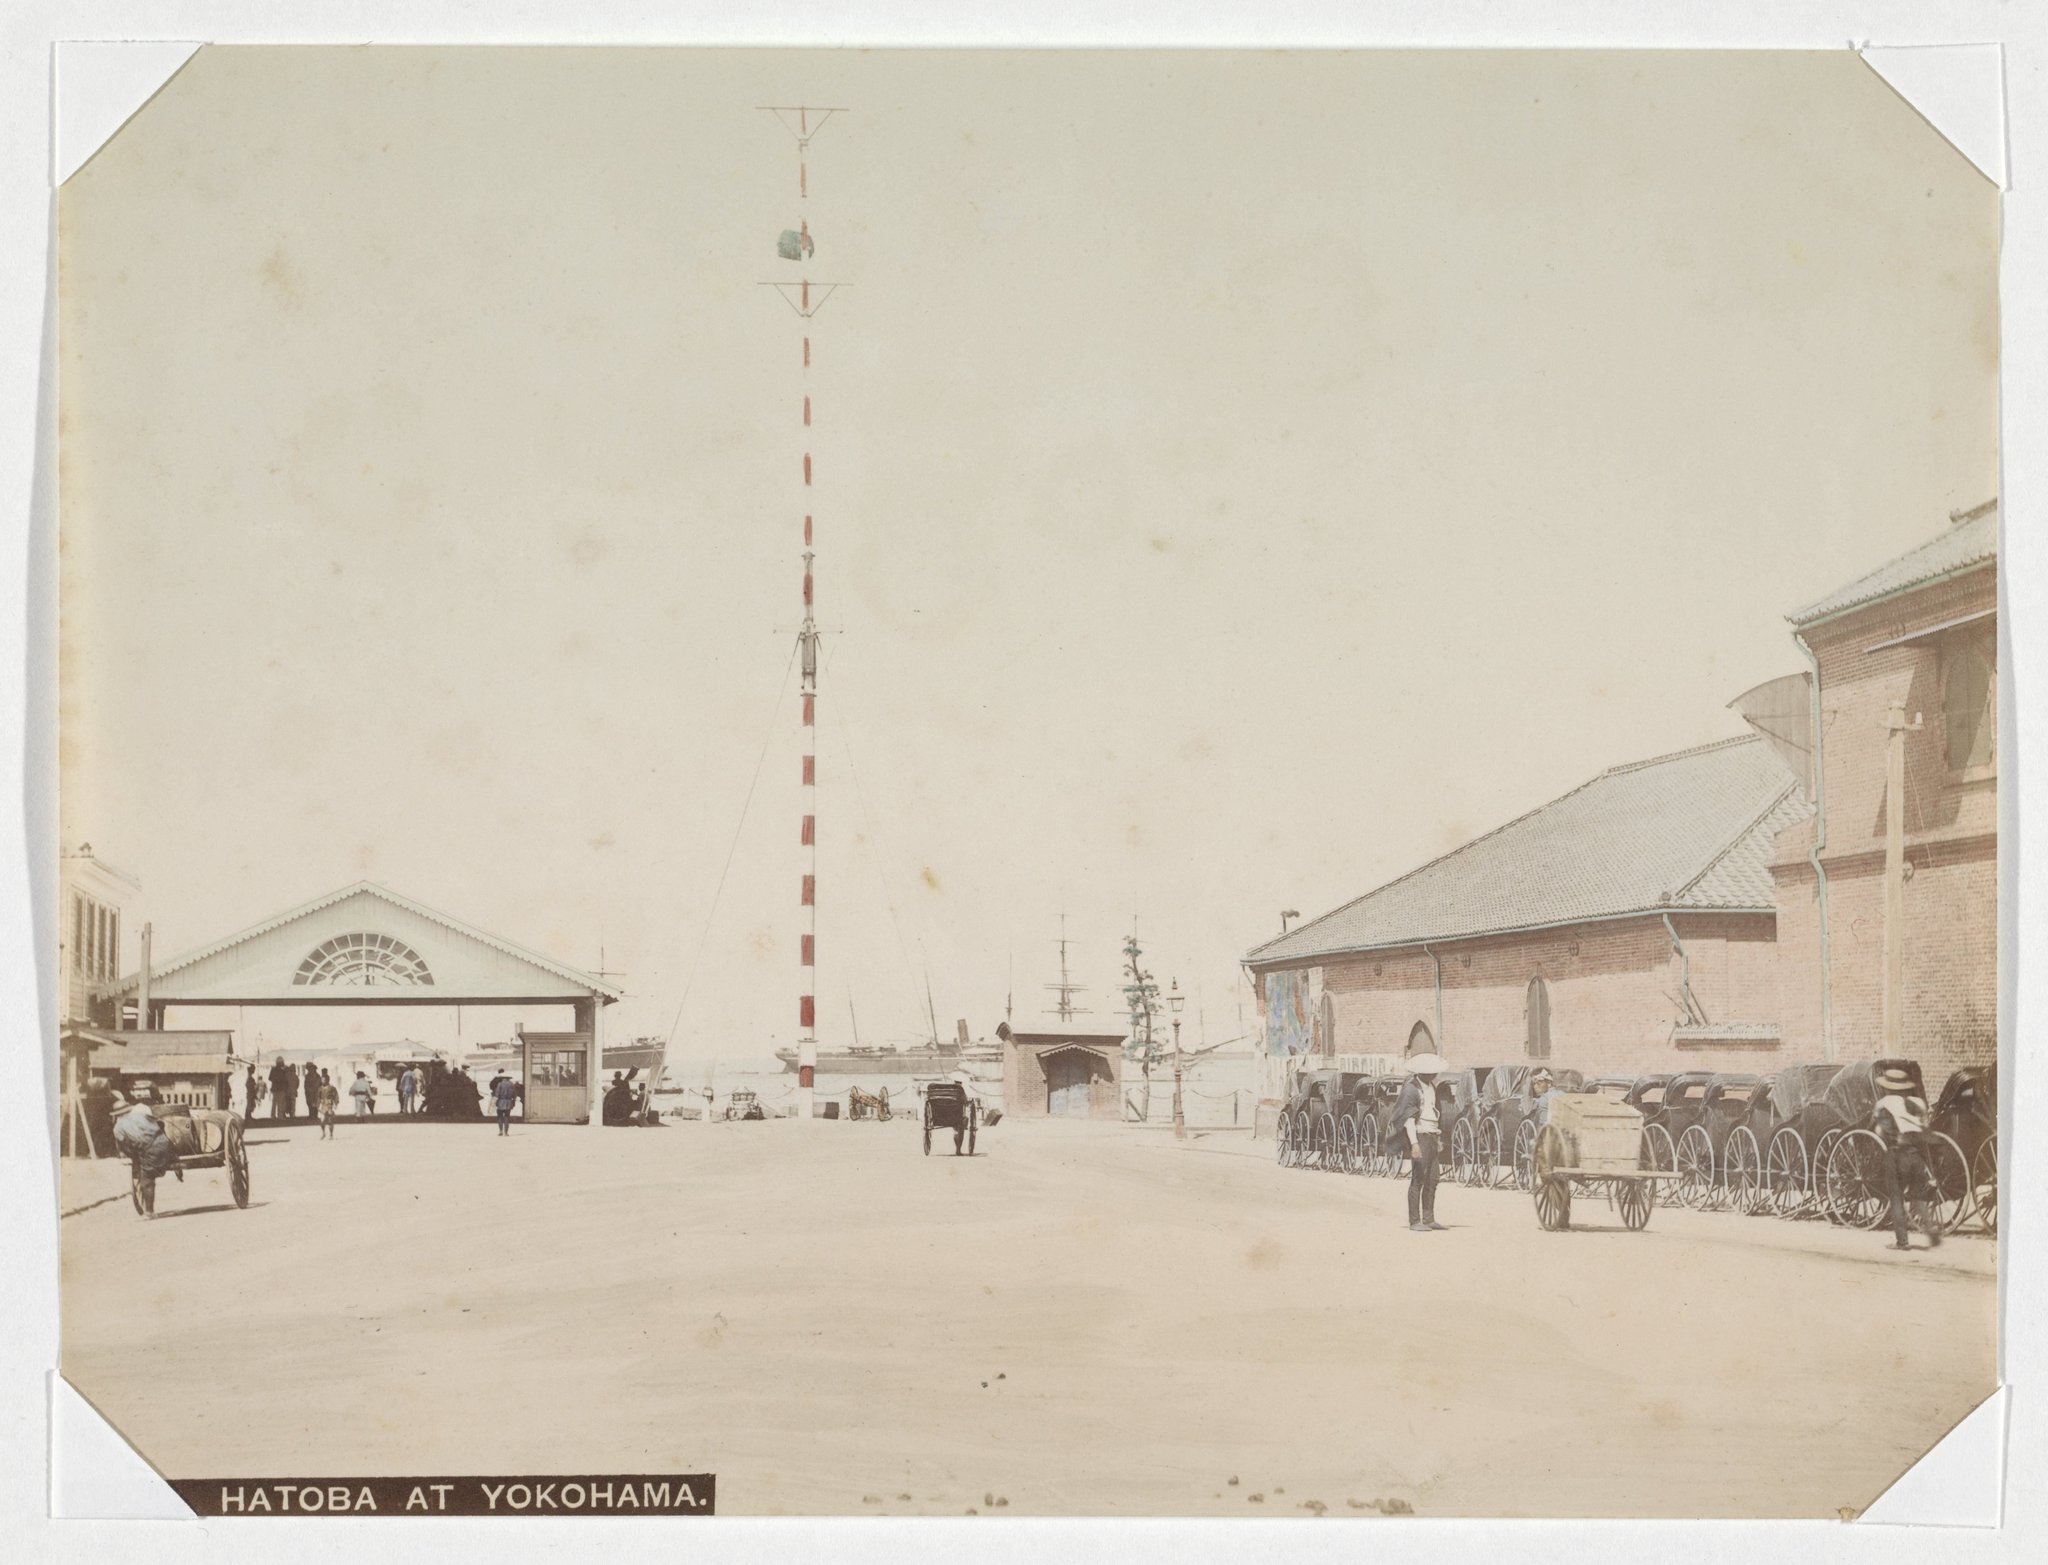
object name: photograph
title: Hatoba at Yokohama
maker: Anonymous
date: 1890-1894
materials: cardboard, paper, photographic support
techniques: albumen print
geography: yokohama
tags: quay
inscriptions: negative number: ‘992’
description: Onderdeel van Album met 69 foto's van een reis door Japan.